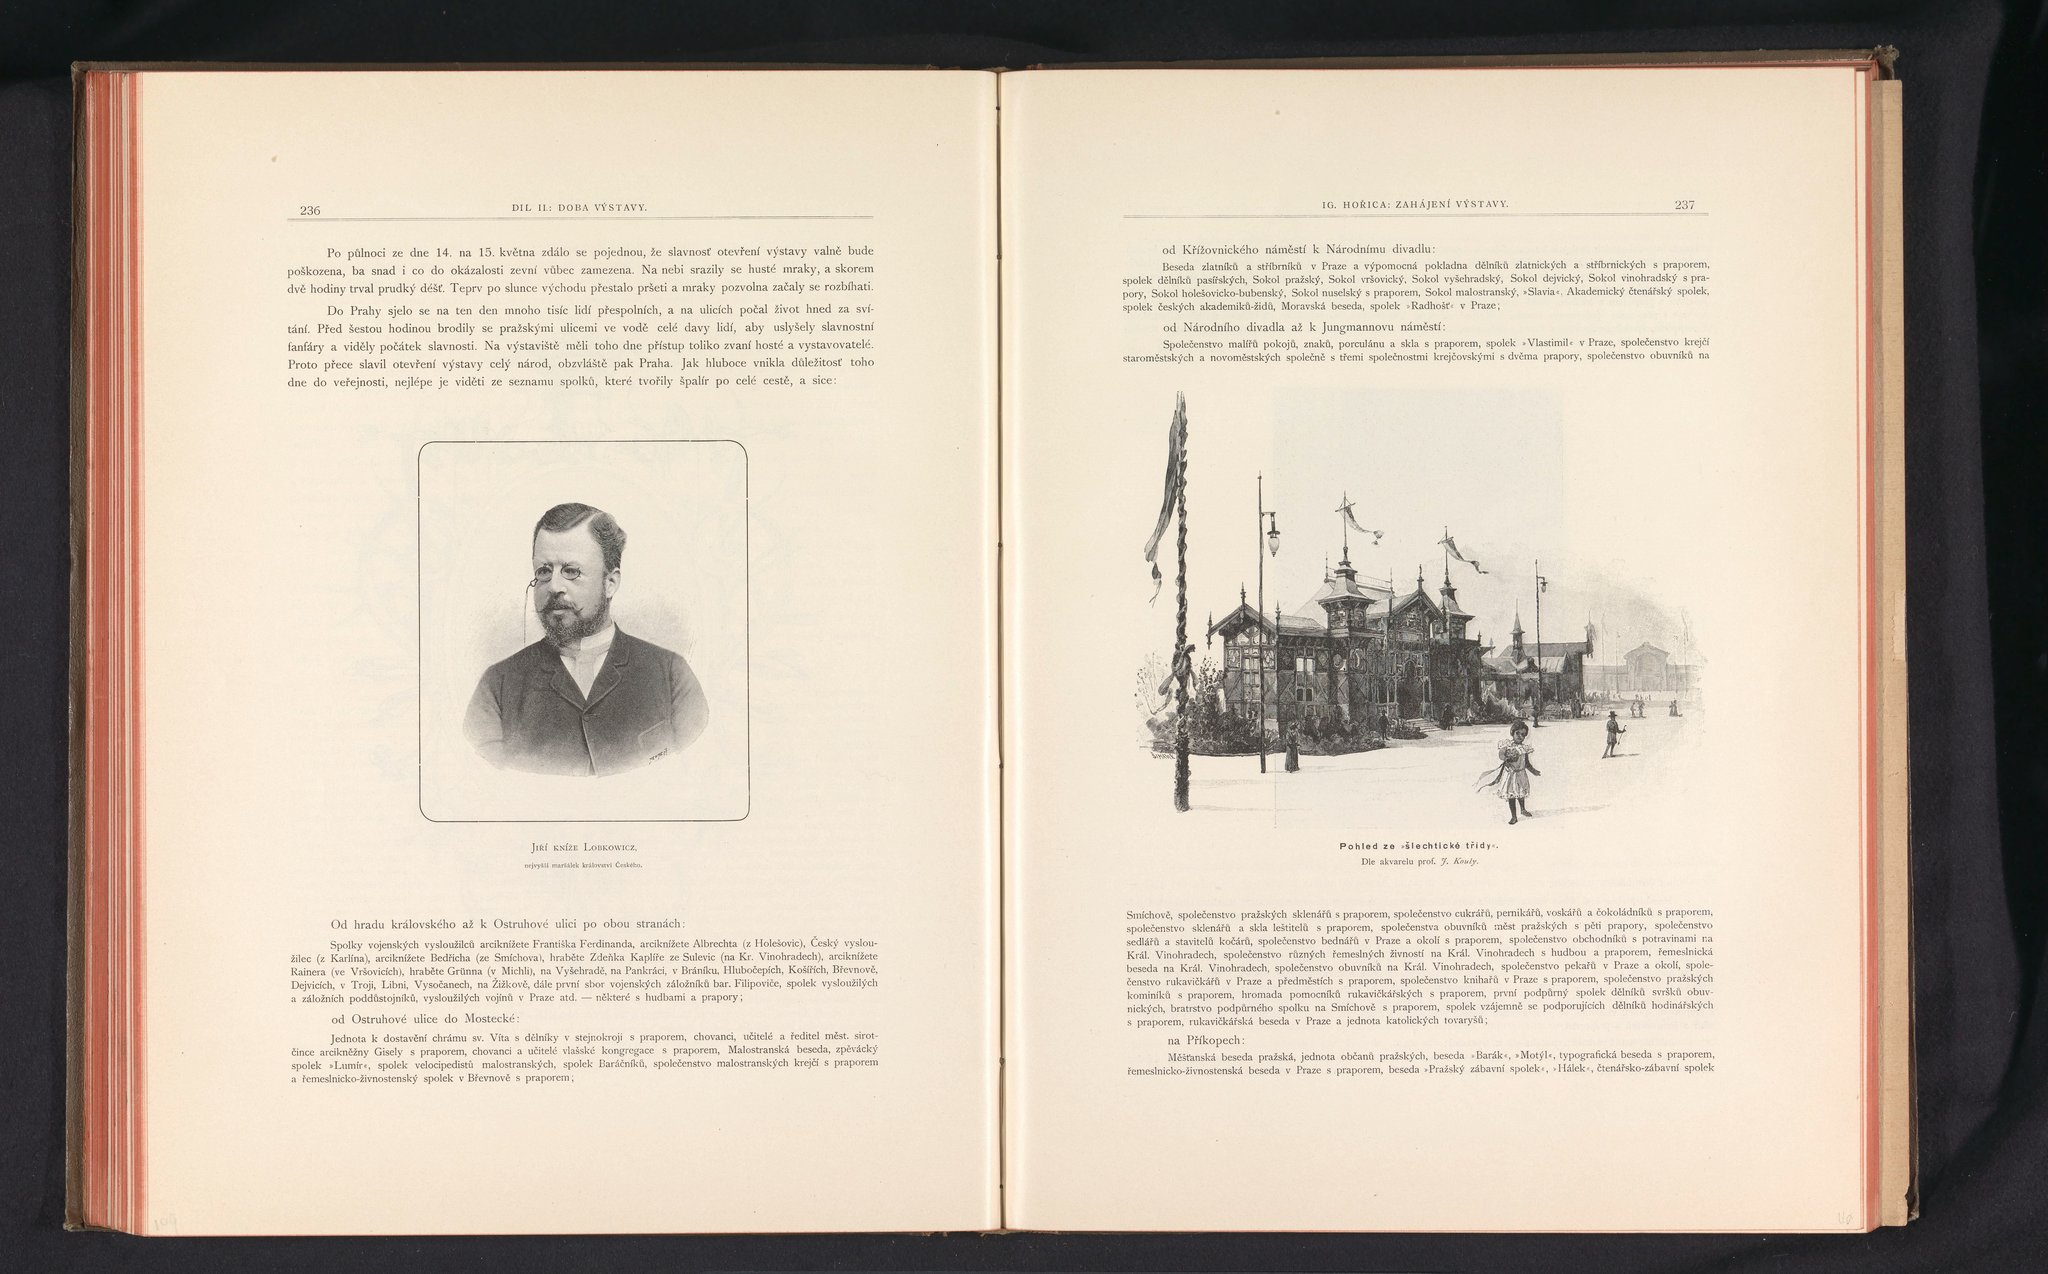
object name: page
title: Pohled ze ,,slechtické tridy''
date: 1891-1893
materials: paper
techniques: autotype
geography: prague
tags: façade (of house or building), temporary exhibition, 'salon'